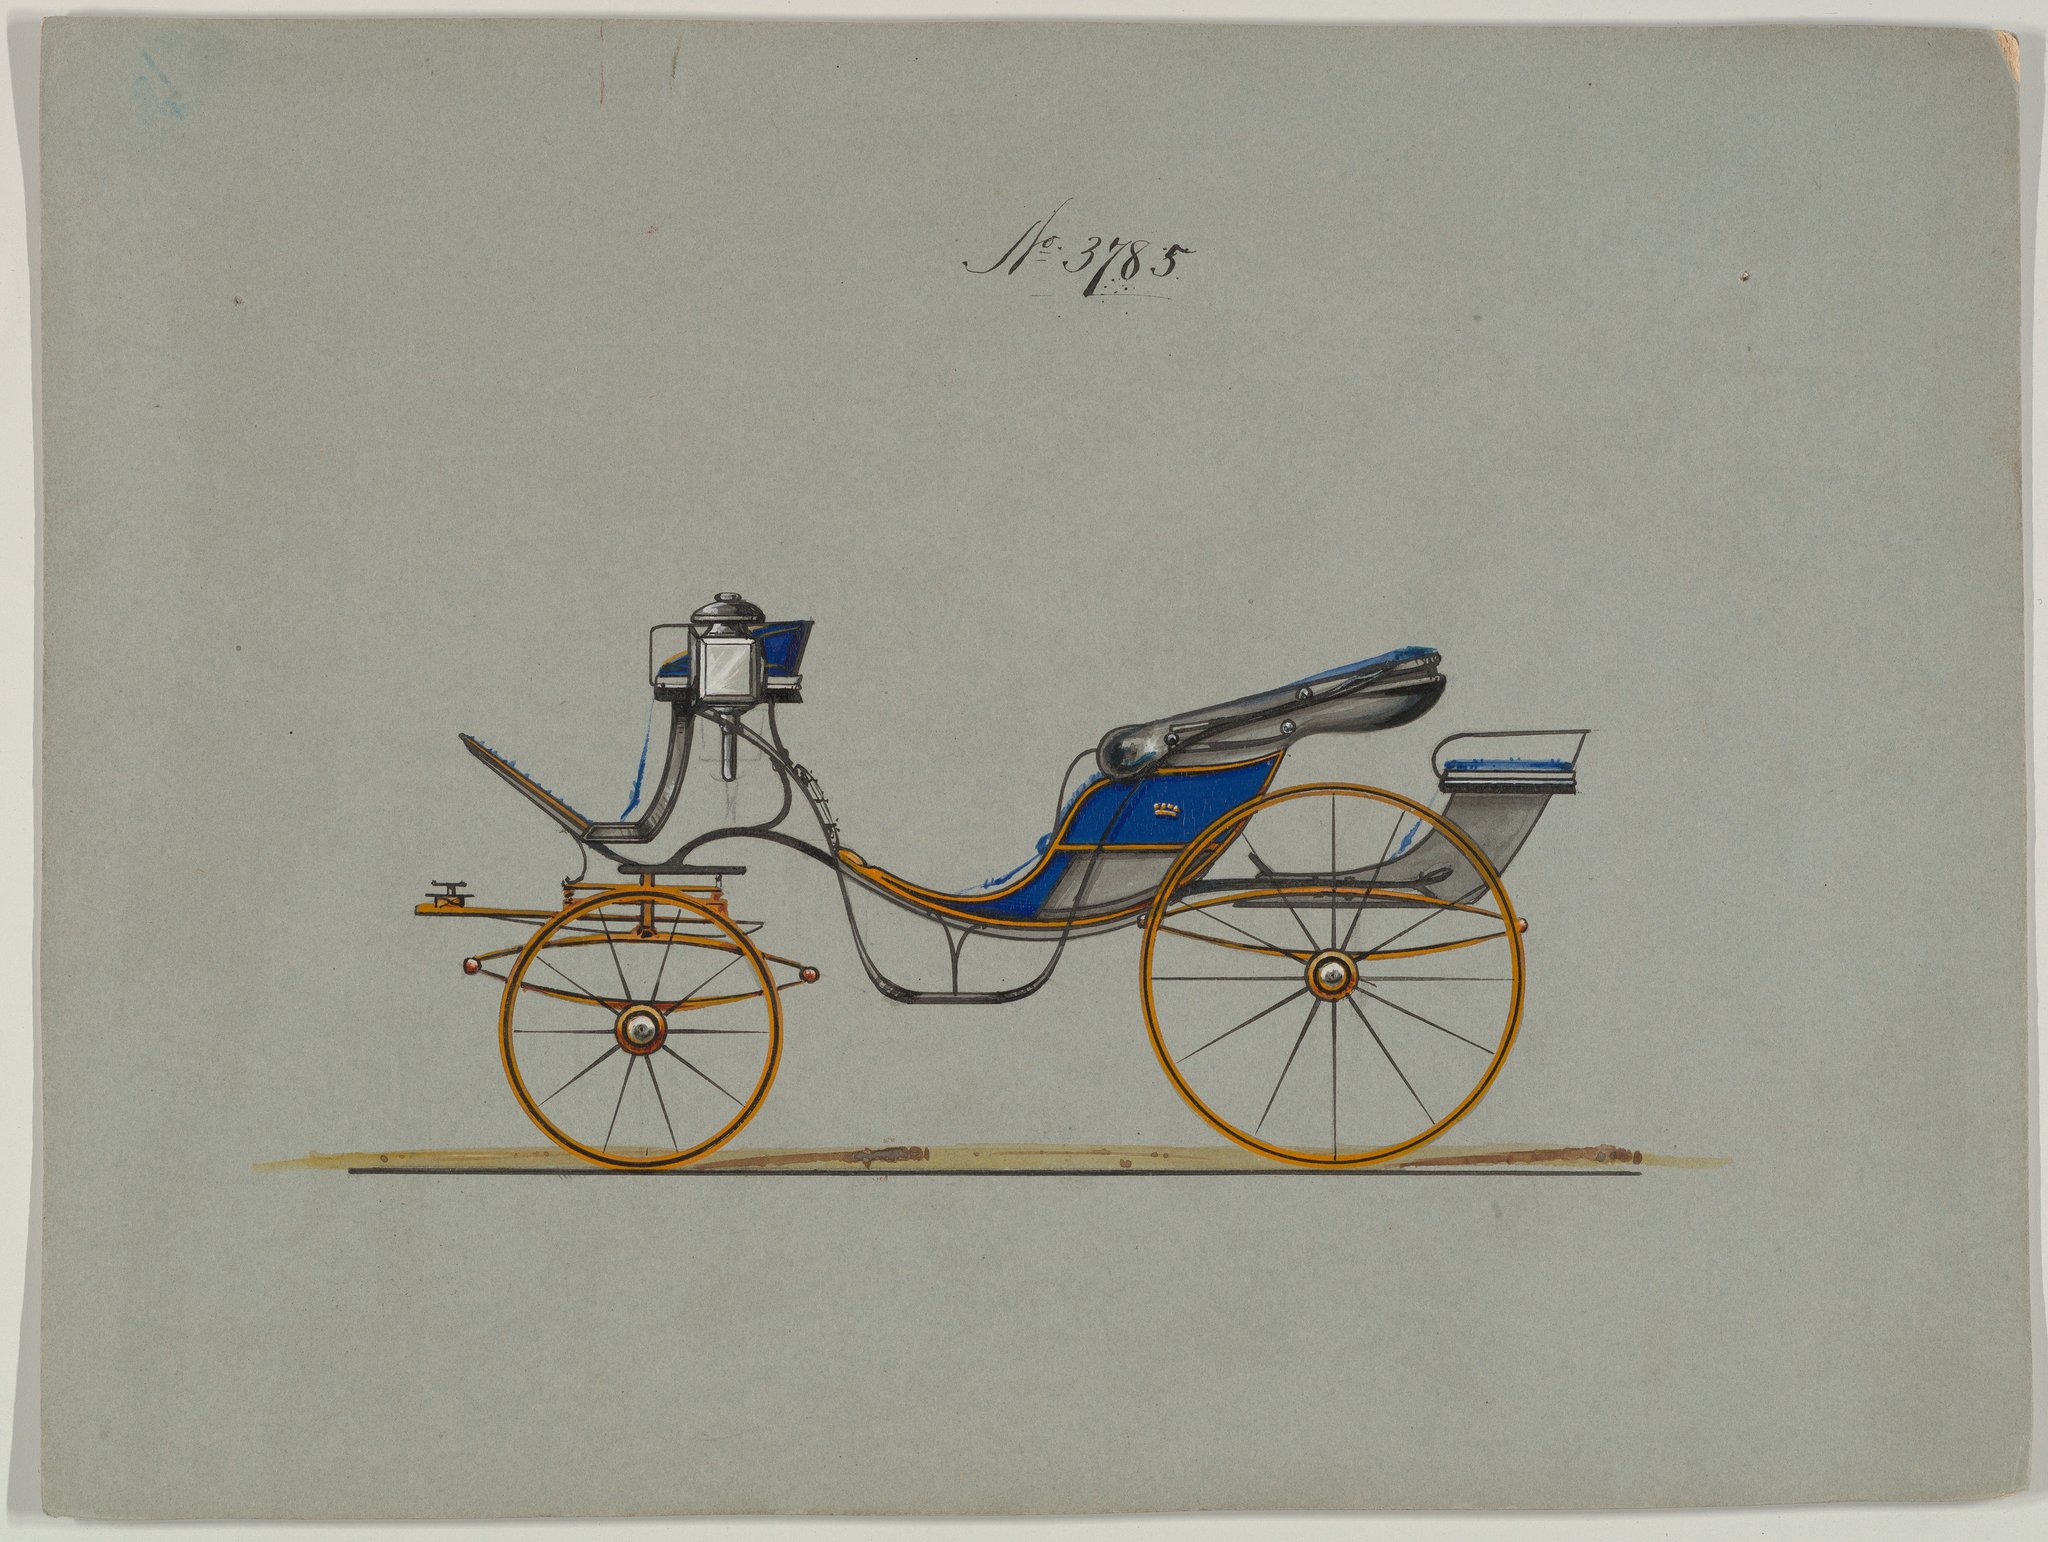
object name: drawing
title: Design for Cabriolet or Victoria, no. 3785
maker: brewster & co.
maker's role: manufacturer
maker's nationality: american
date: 1882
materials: gum arabic, ink, watercolor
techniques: pen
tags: carriages